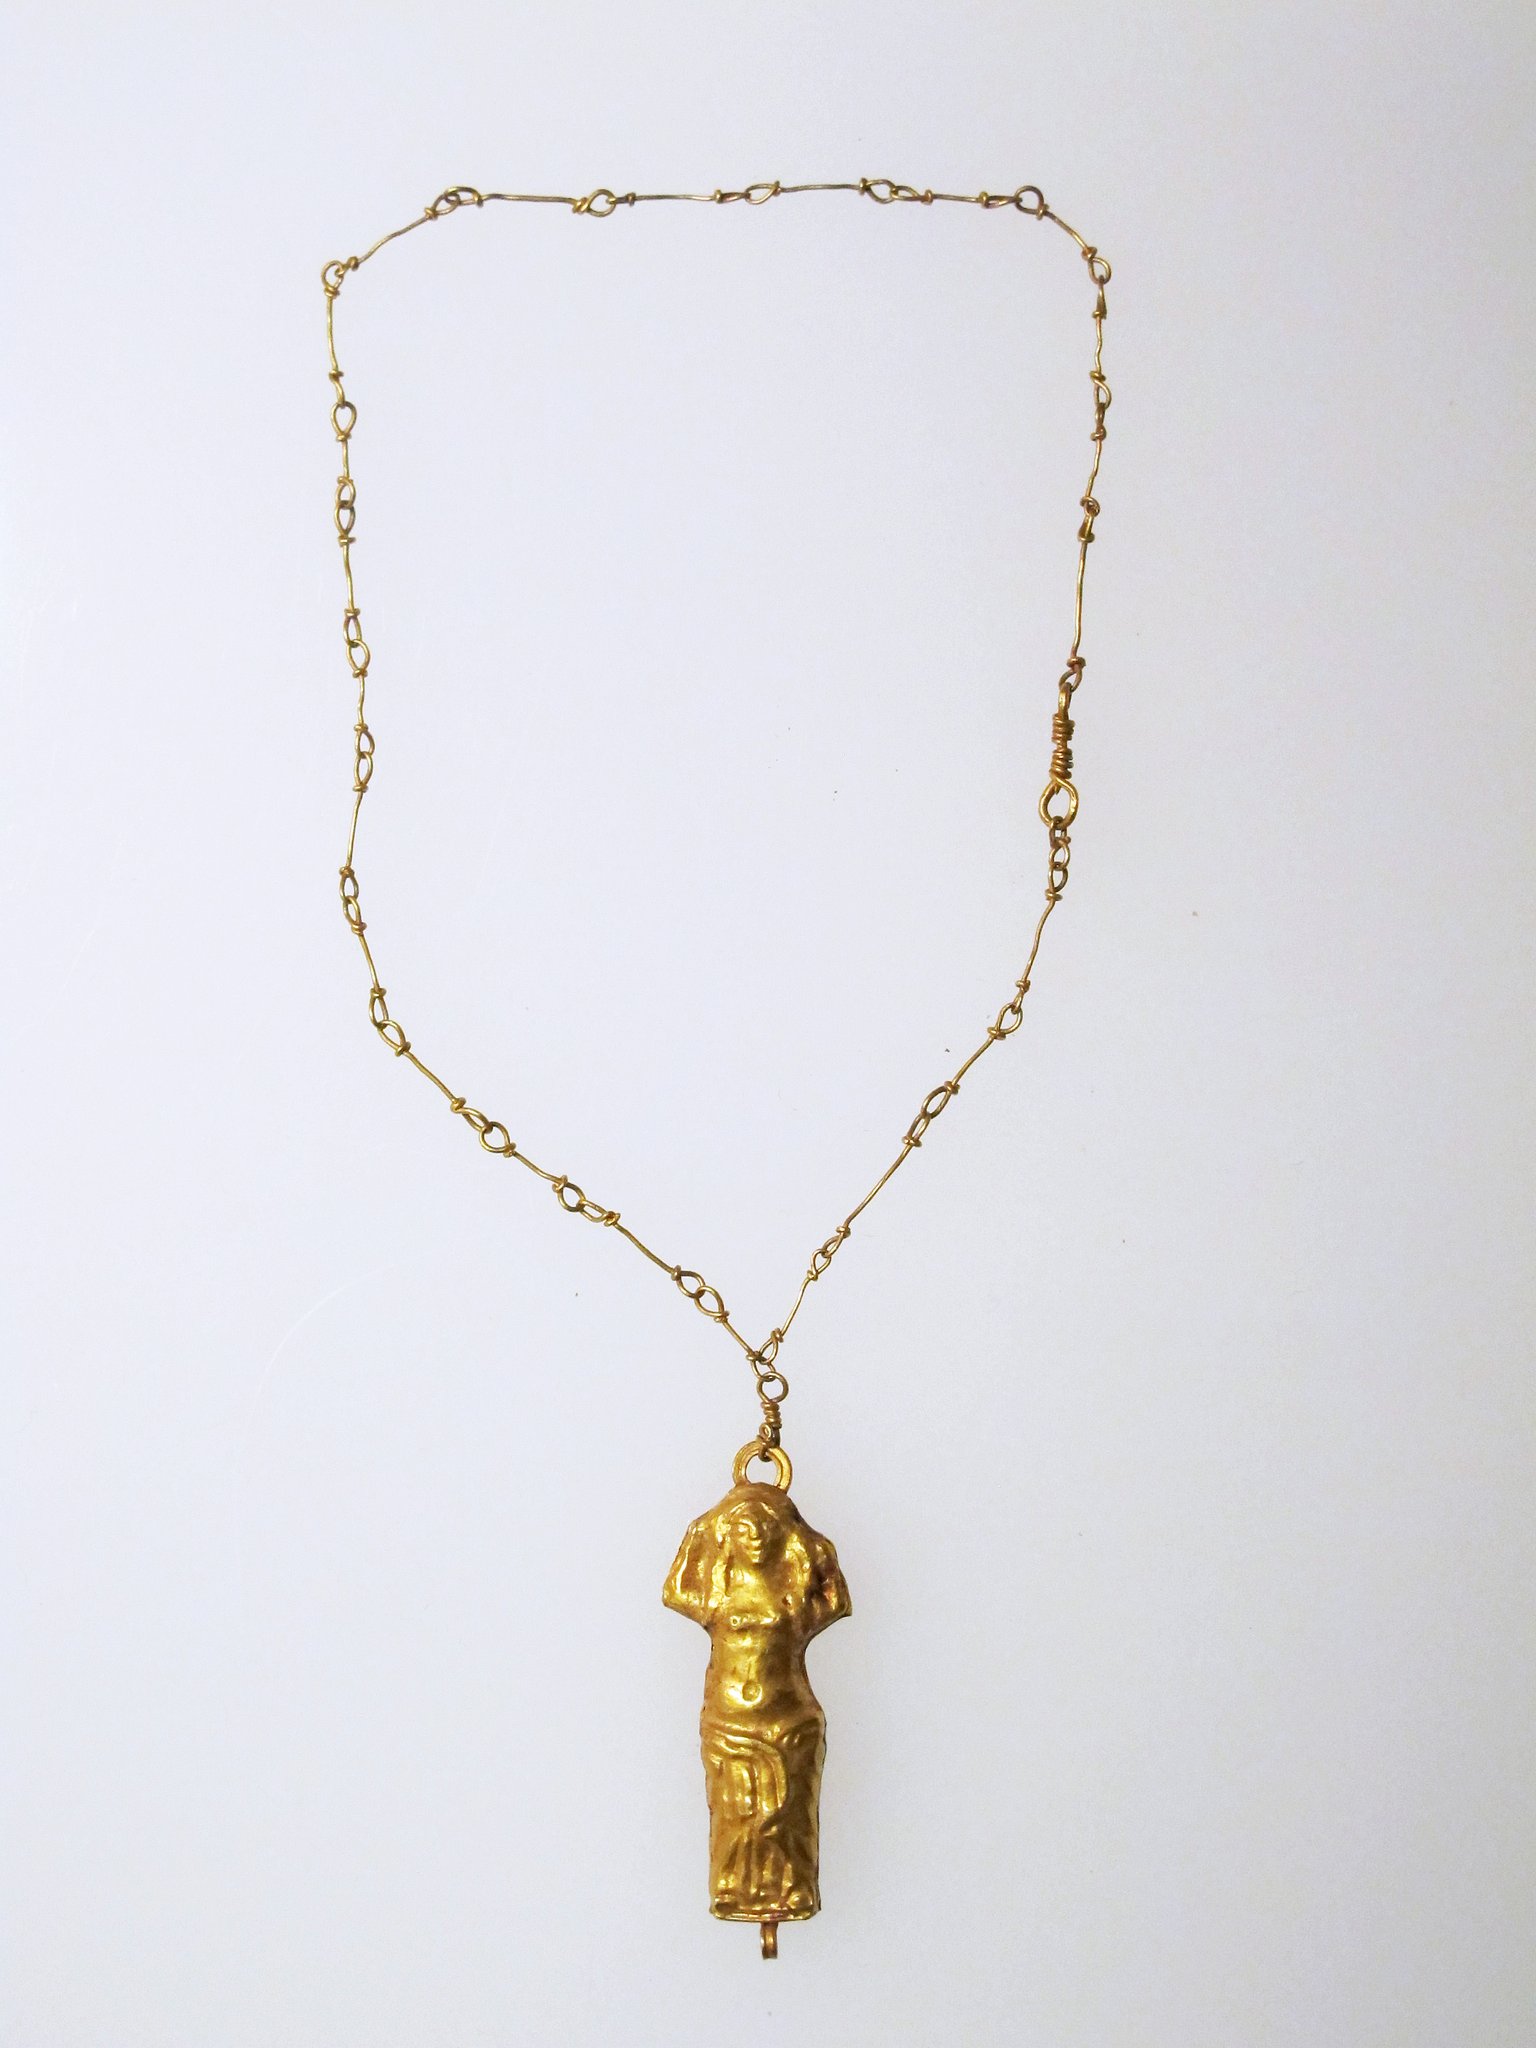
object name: necklace, chain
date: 7000 BCE-330 CE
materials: glass, gold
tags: women